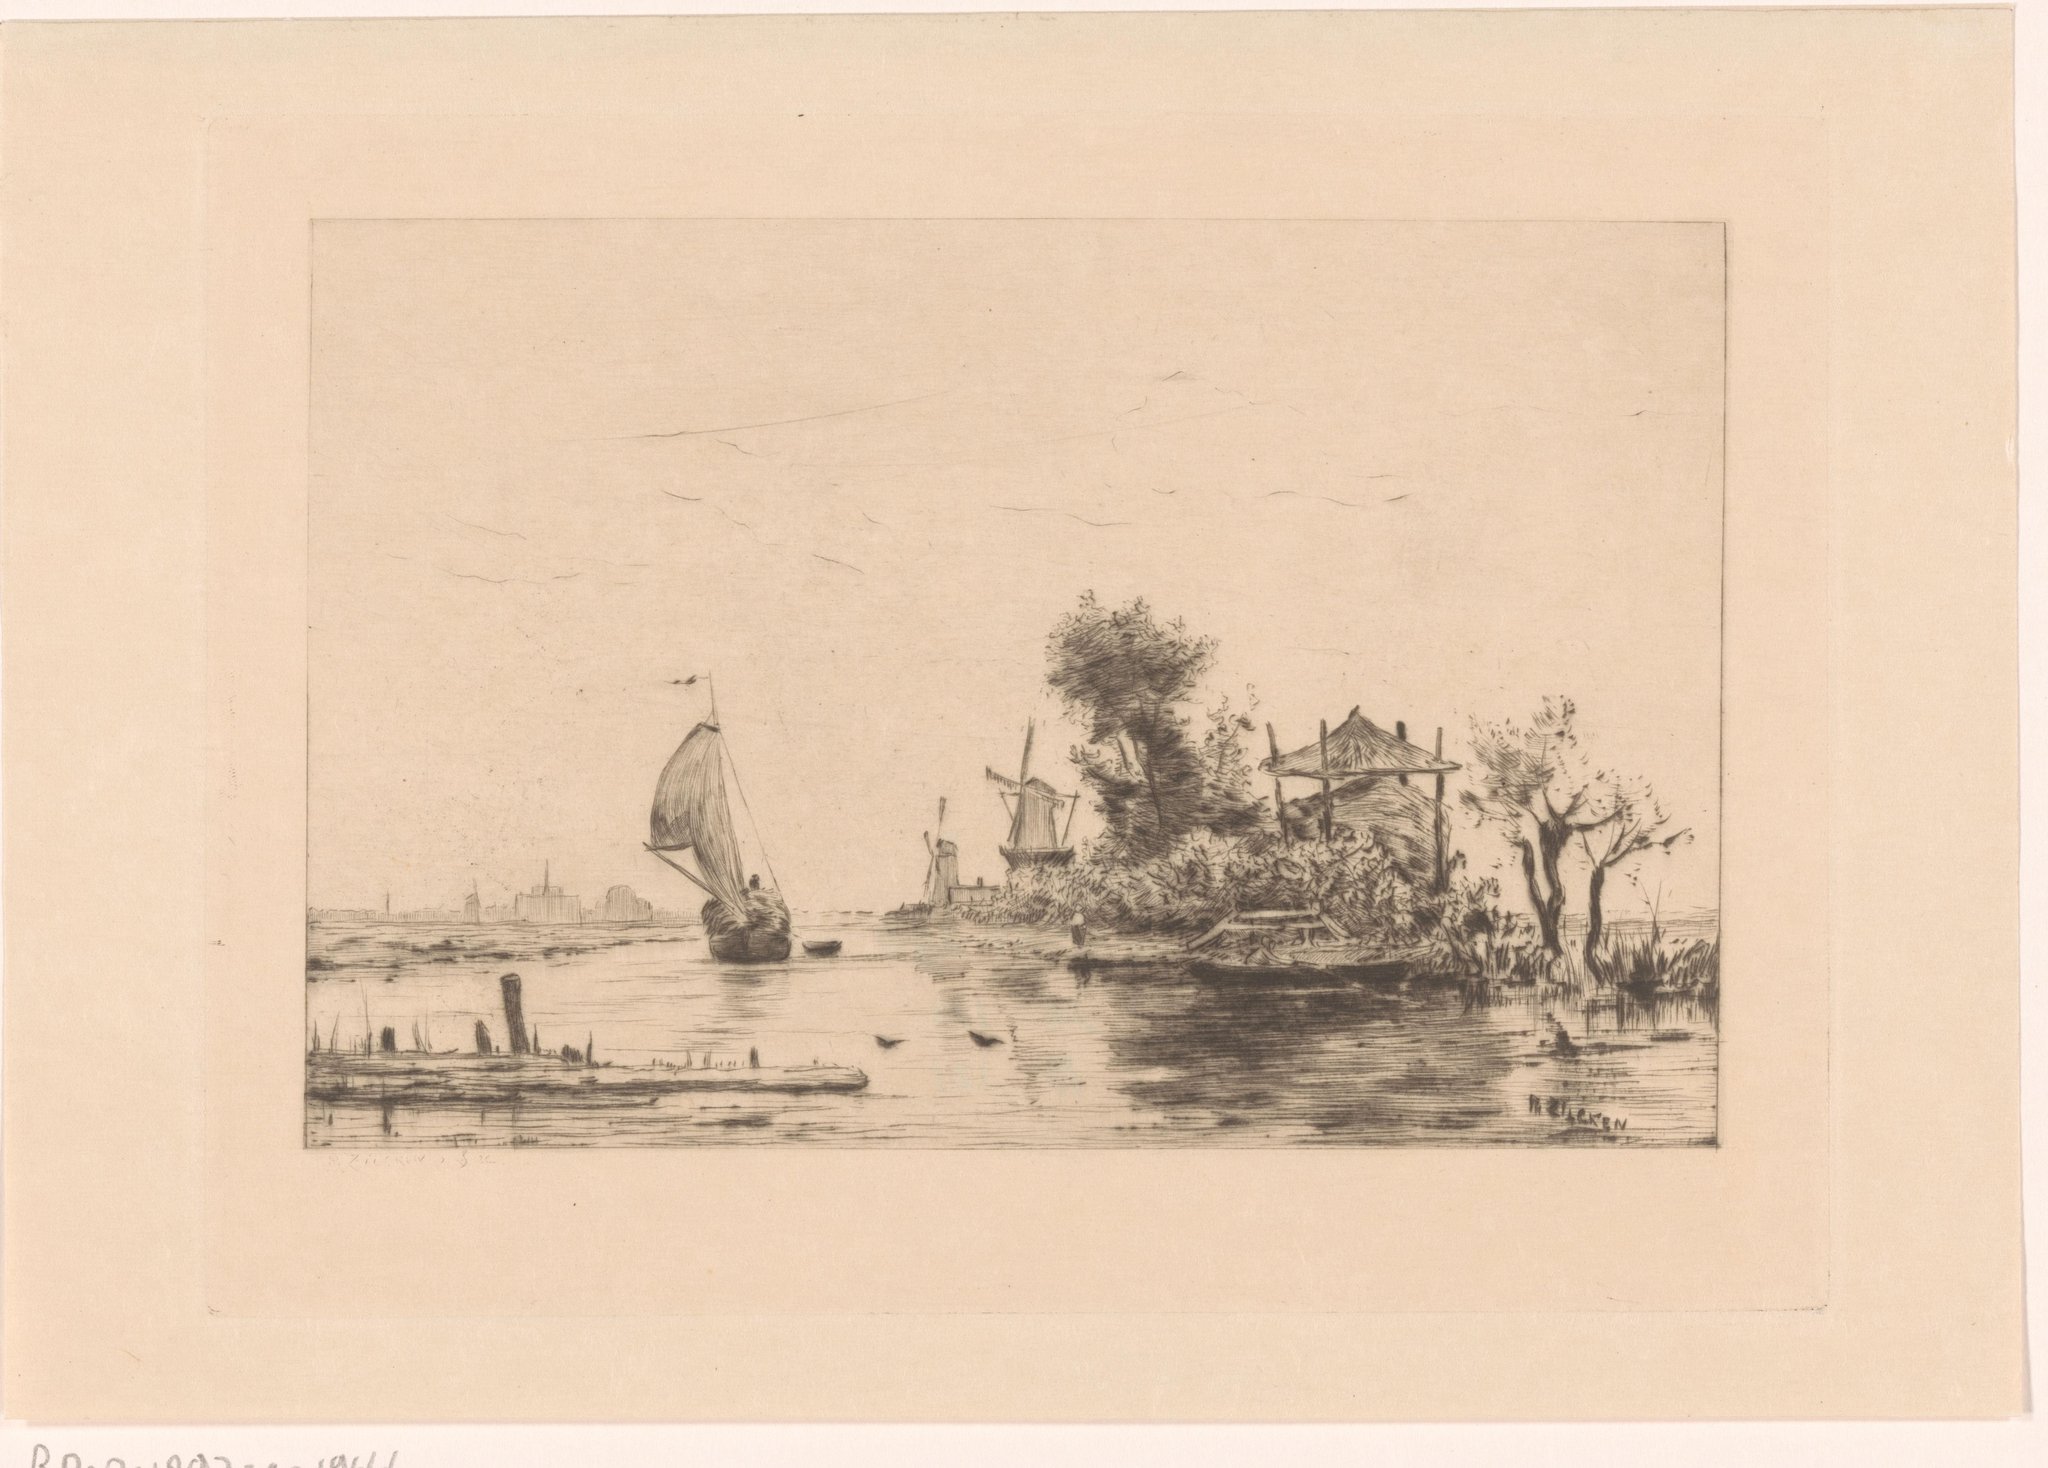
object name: print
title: Delfshaven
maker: philip zilcken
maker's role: draughtsman, painter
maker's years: 1857-1930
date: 1867-1890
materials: paper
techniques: drypoint, intaglio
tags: prospect of village, silhouette of village, sailing-ship, sailing-boat, windmill in landscape, hay-stack, delfshaven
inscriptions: collector's mark: Lugt 2228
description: Waterlandschap met zeilboot, molens, een hooibaal en in de verte Delfshaven.